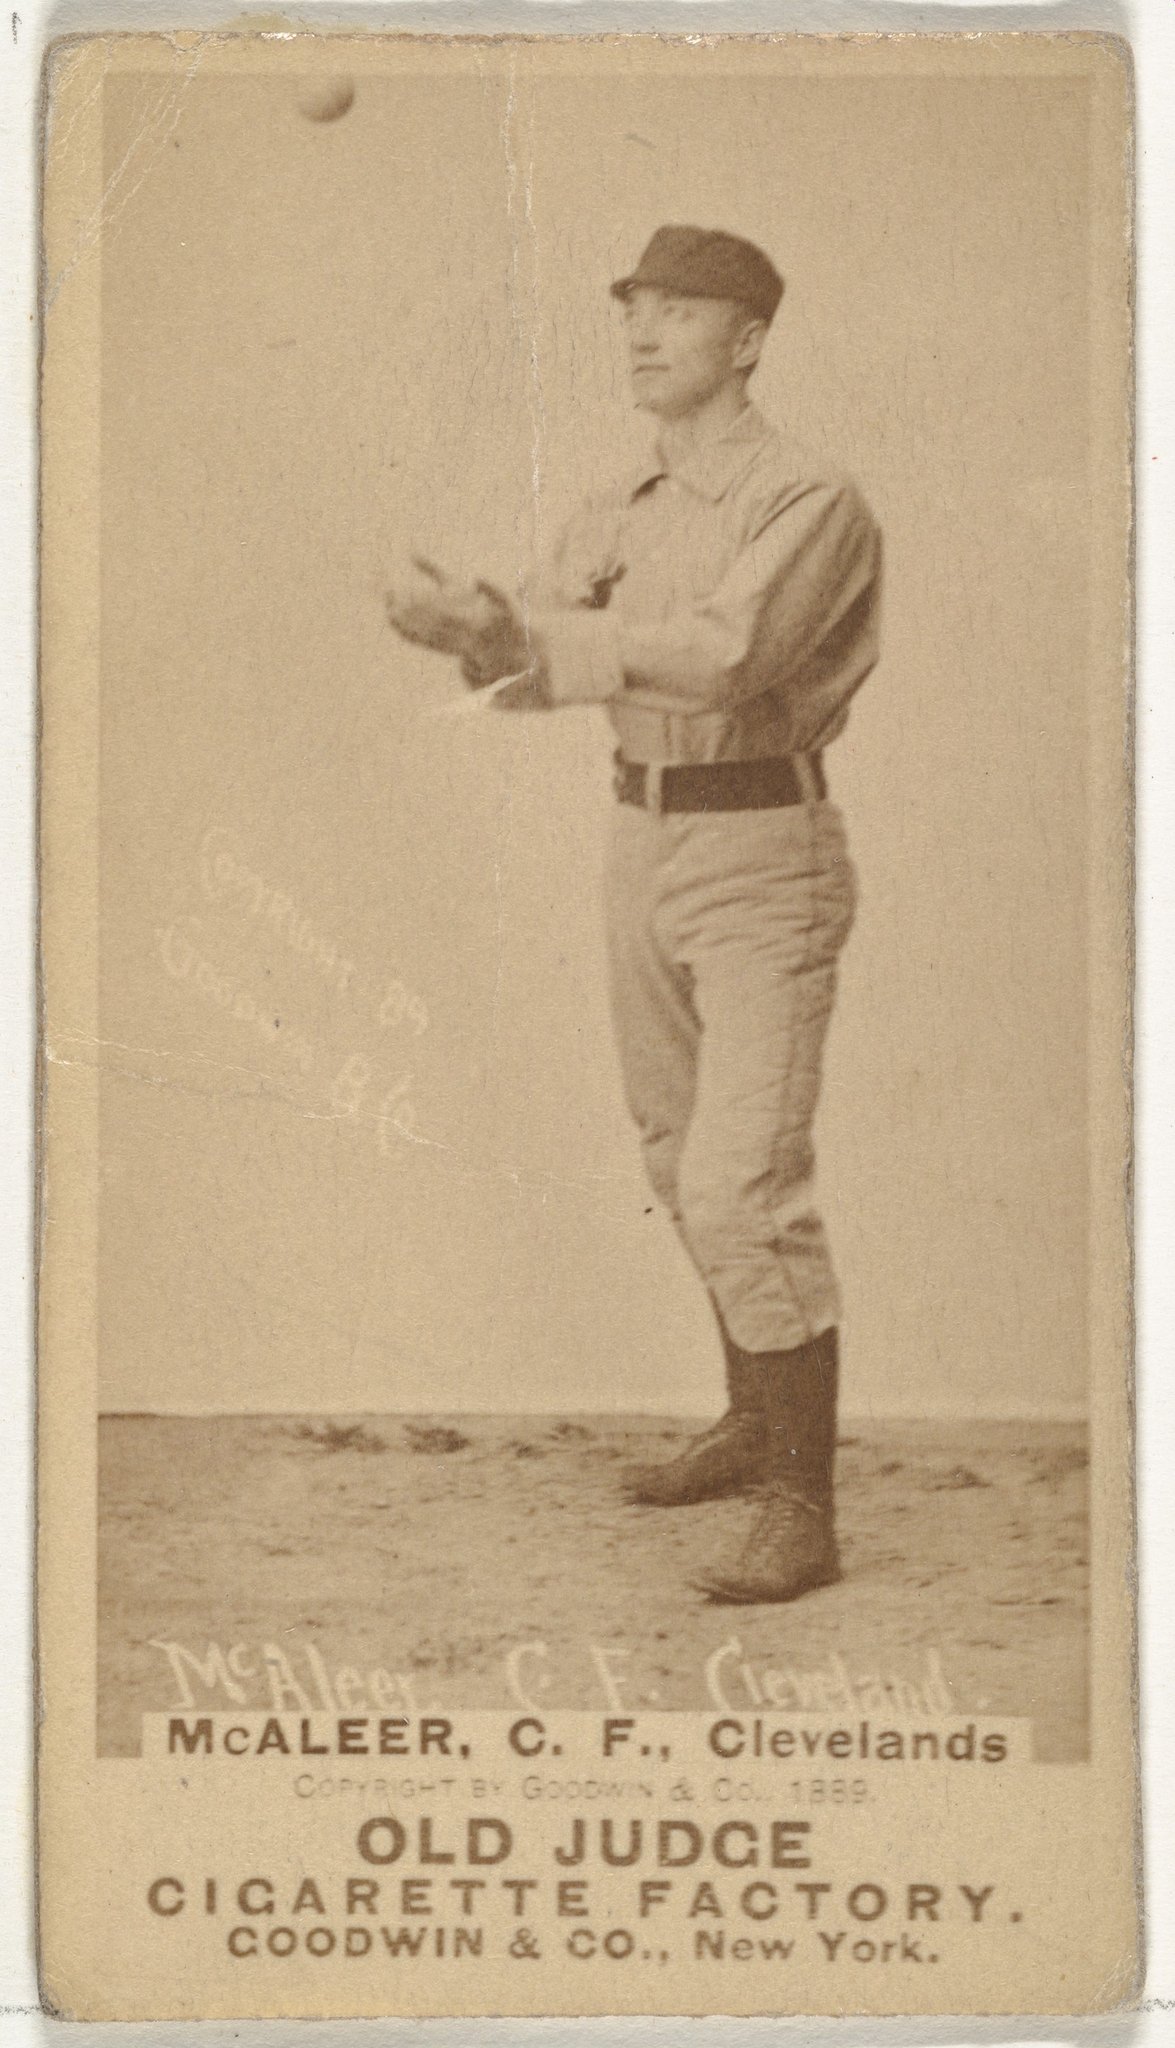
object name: baseball card, photograph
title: Jimmy "Loafer" McAleer, Center Field, Cleveland, from the Old Judge series (N172) for Old Judge Cigarettes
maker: goodwin & company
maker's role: publisher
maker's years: 1850-1950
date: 1889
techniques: albumen silver print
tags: men,portraits,baseball,athletes